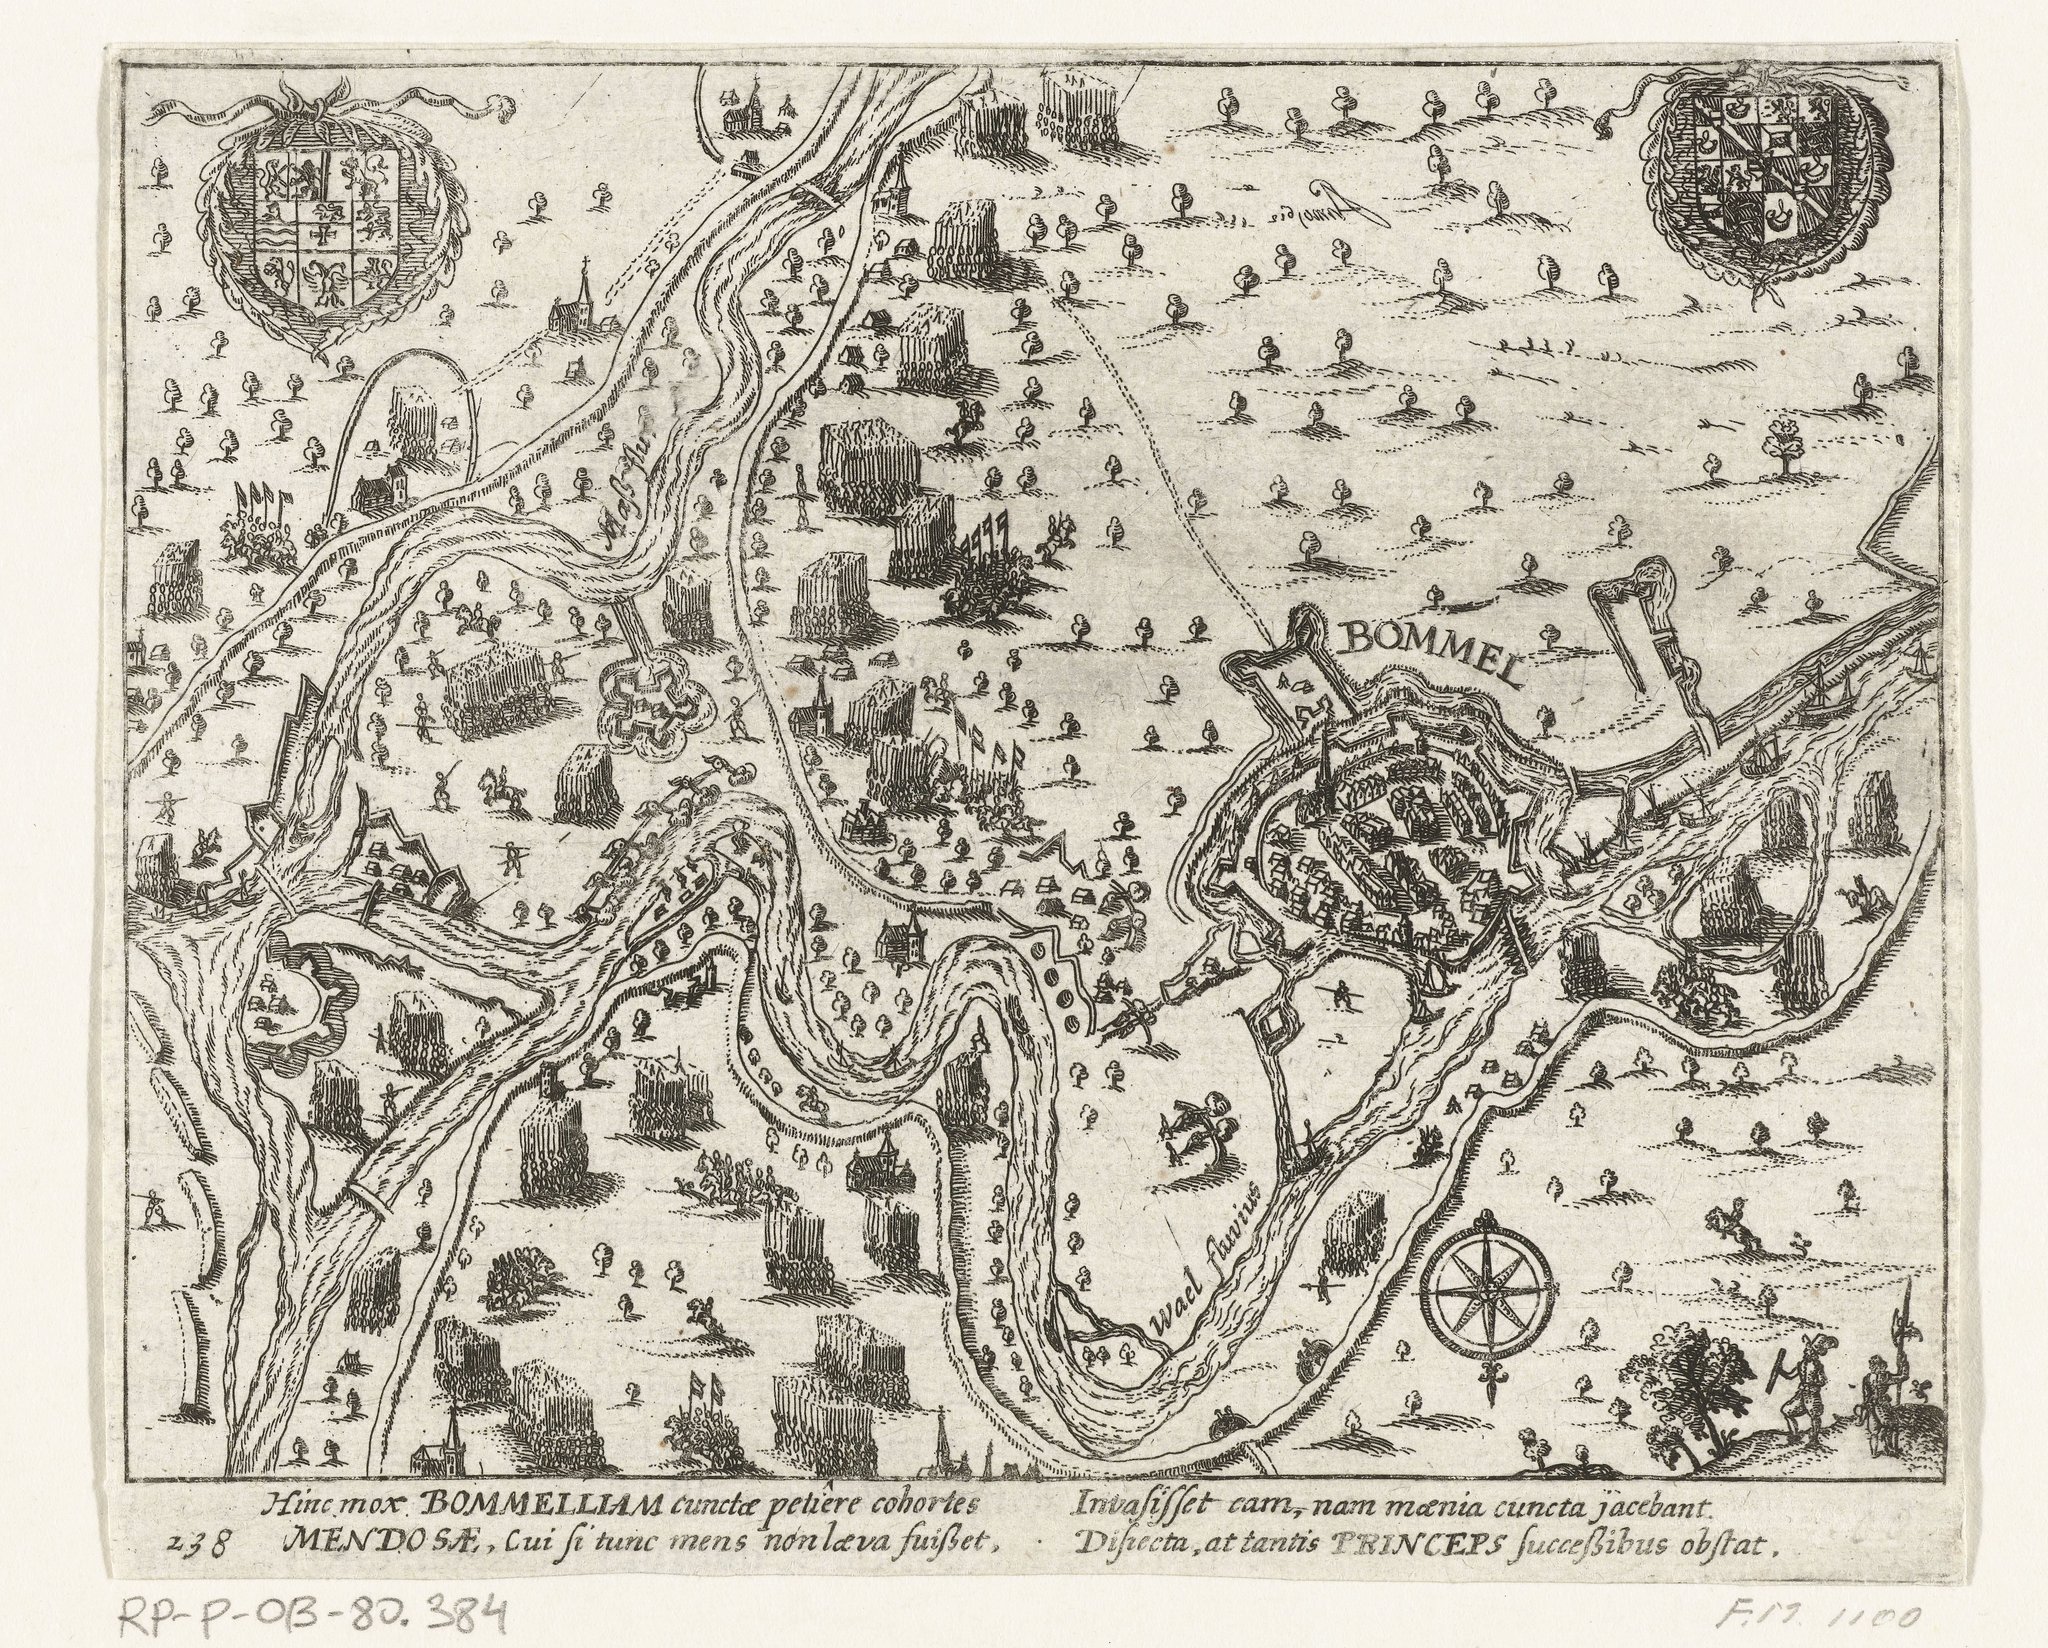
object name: print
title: Belegering van Zaltbommel en andere gevechten in de Bommelerwaard, 1599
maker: Anonymous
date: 1613-1615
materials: paper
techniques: etching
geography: northern netherlands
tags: the hague, maurice (prince of orange), siege, position war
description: Belegering door de Spanjaarden onder Mendoza van Zaltbommel en andere sterkten in de Bommelerwaard in handen van het Staatse leger onder prins Maurits, zomer 1599. Links de Maas, onderaan de Waal, in het midden Bommel. Bovenaan de wapens van de Staten-Generaal en van Maurits. Met onderschrift van 4 regels in het Latijn. Genummerd 238. Bedrukt op achterzijde met tekst in het Latijn.